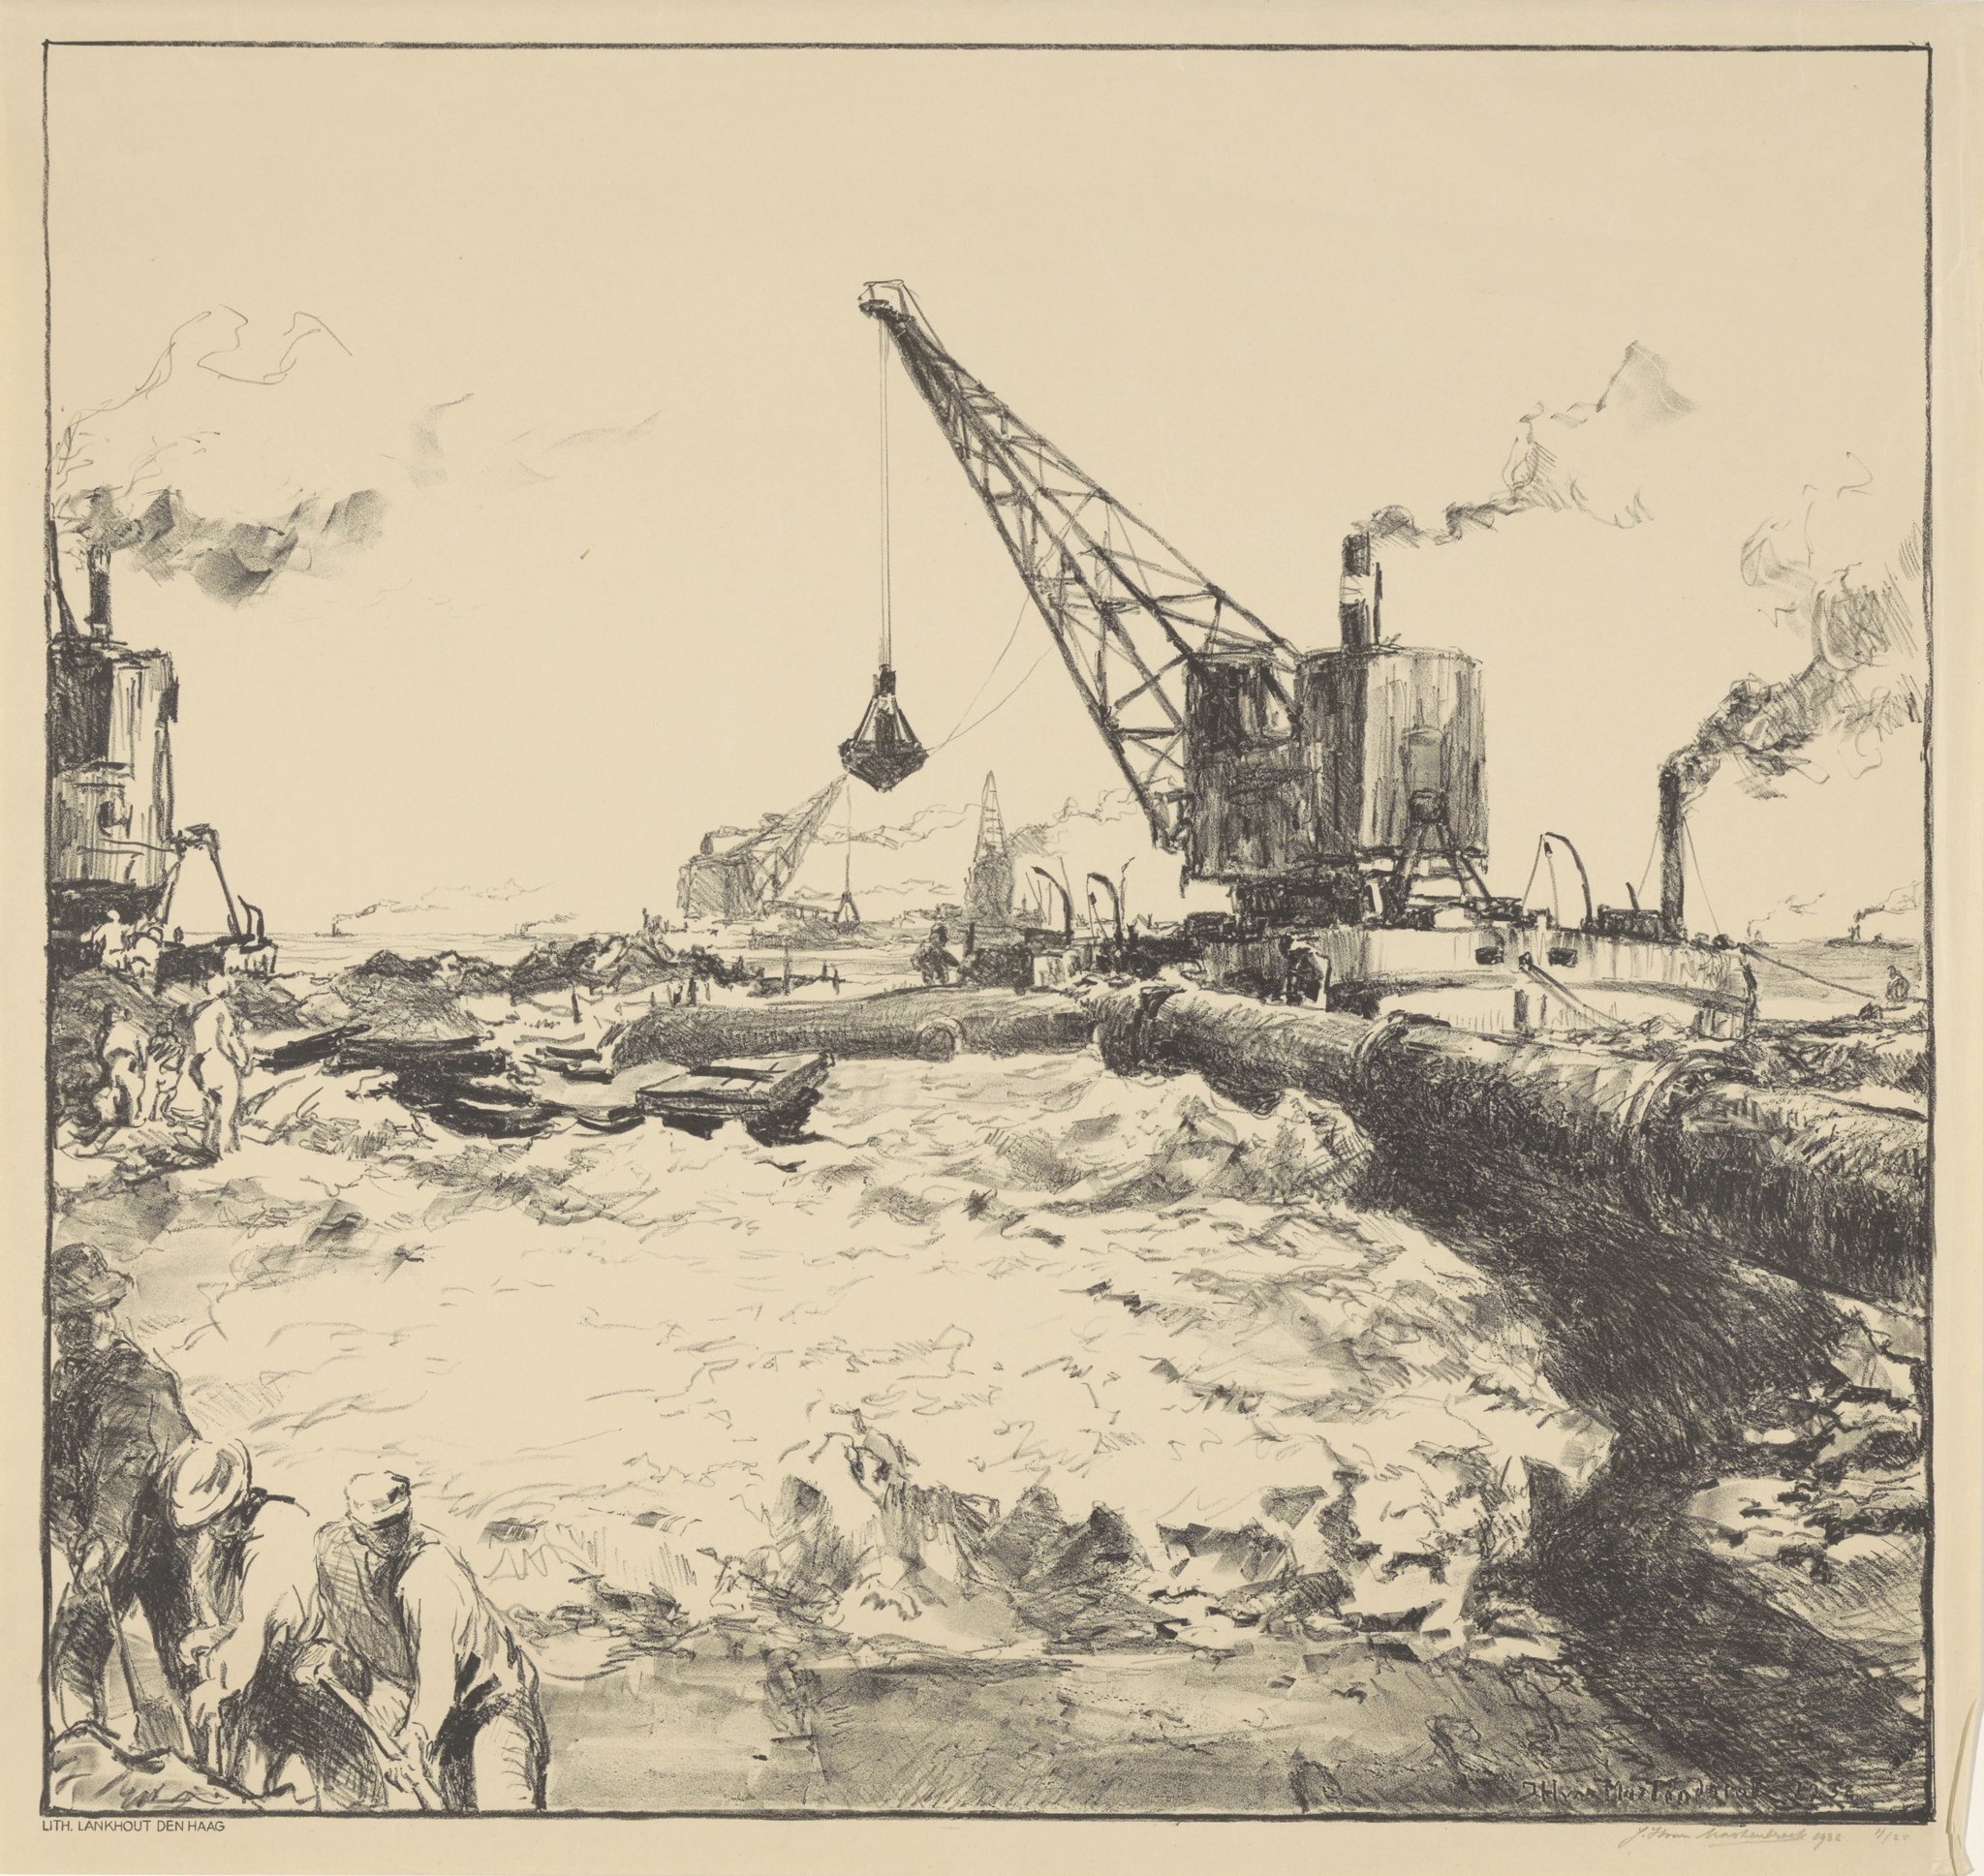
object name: print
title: Zuiderzeewerk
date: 1932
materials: paper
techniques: lithograph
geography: the hague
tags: digging (industrial process), sea, zuiderzee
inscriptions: collector's mark: Lugt 2228